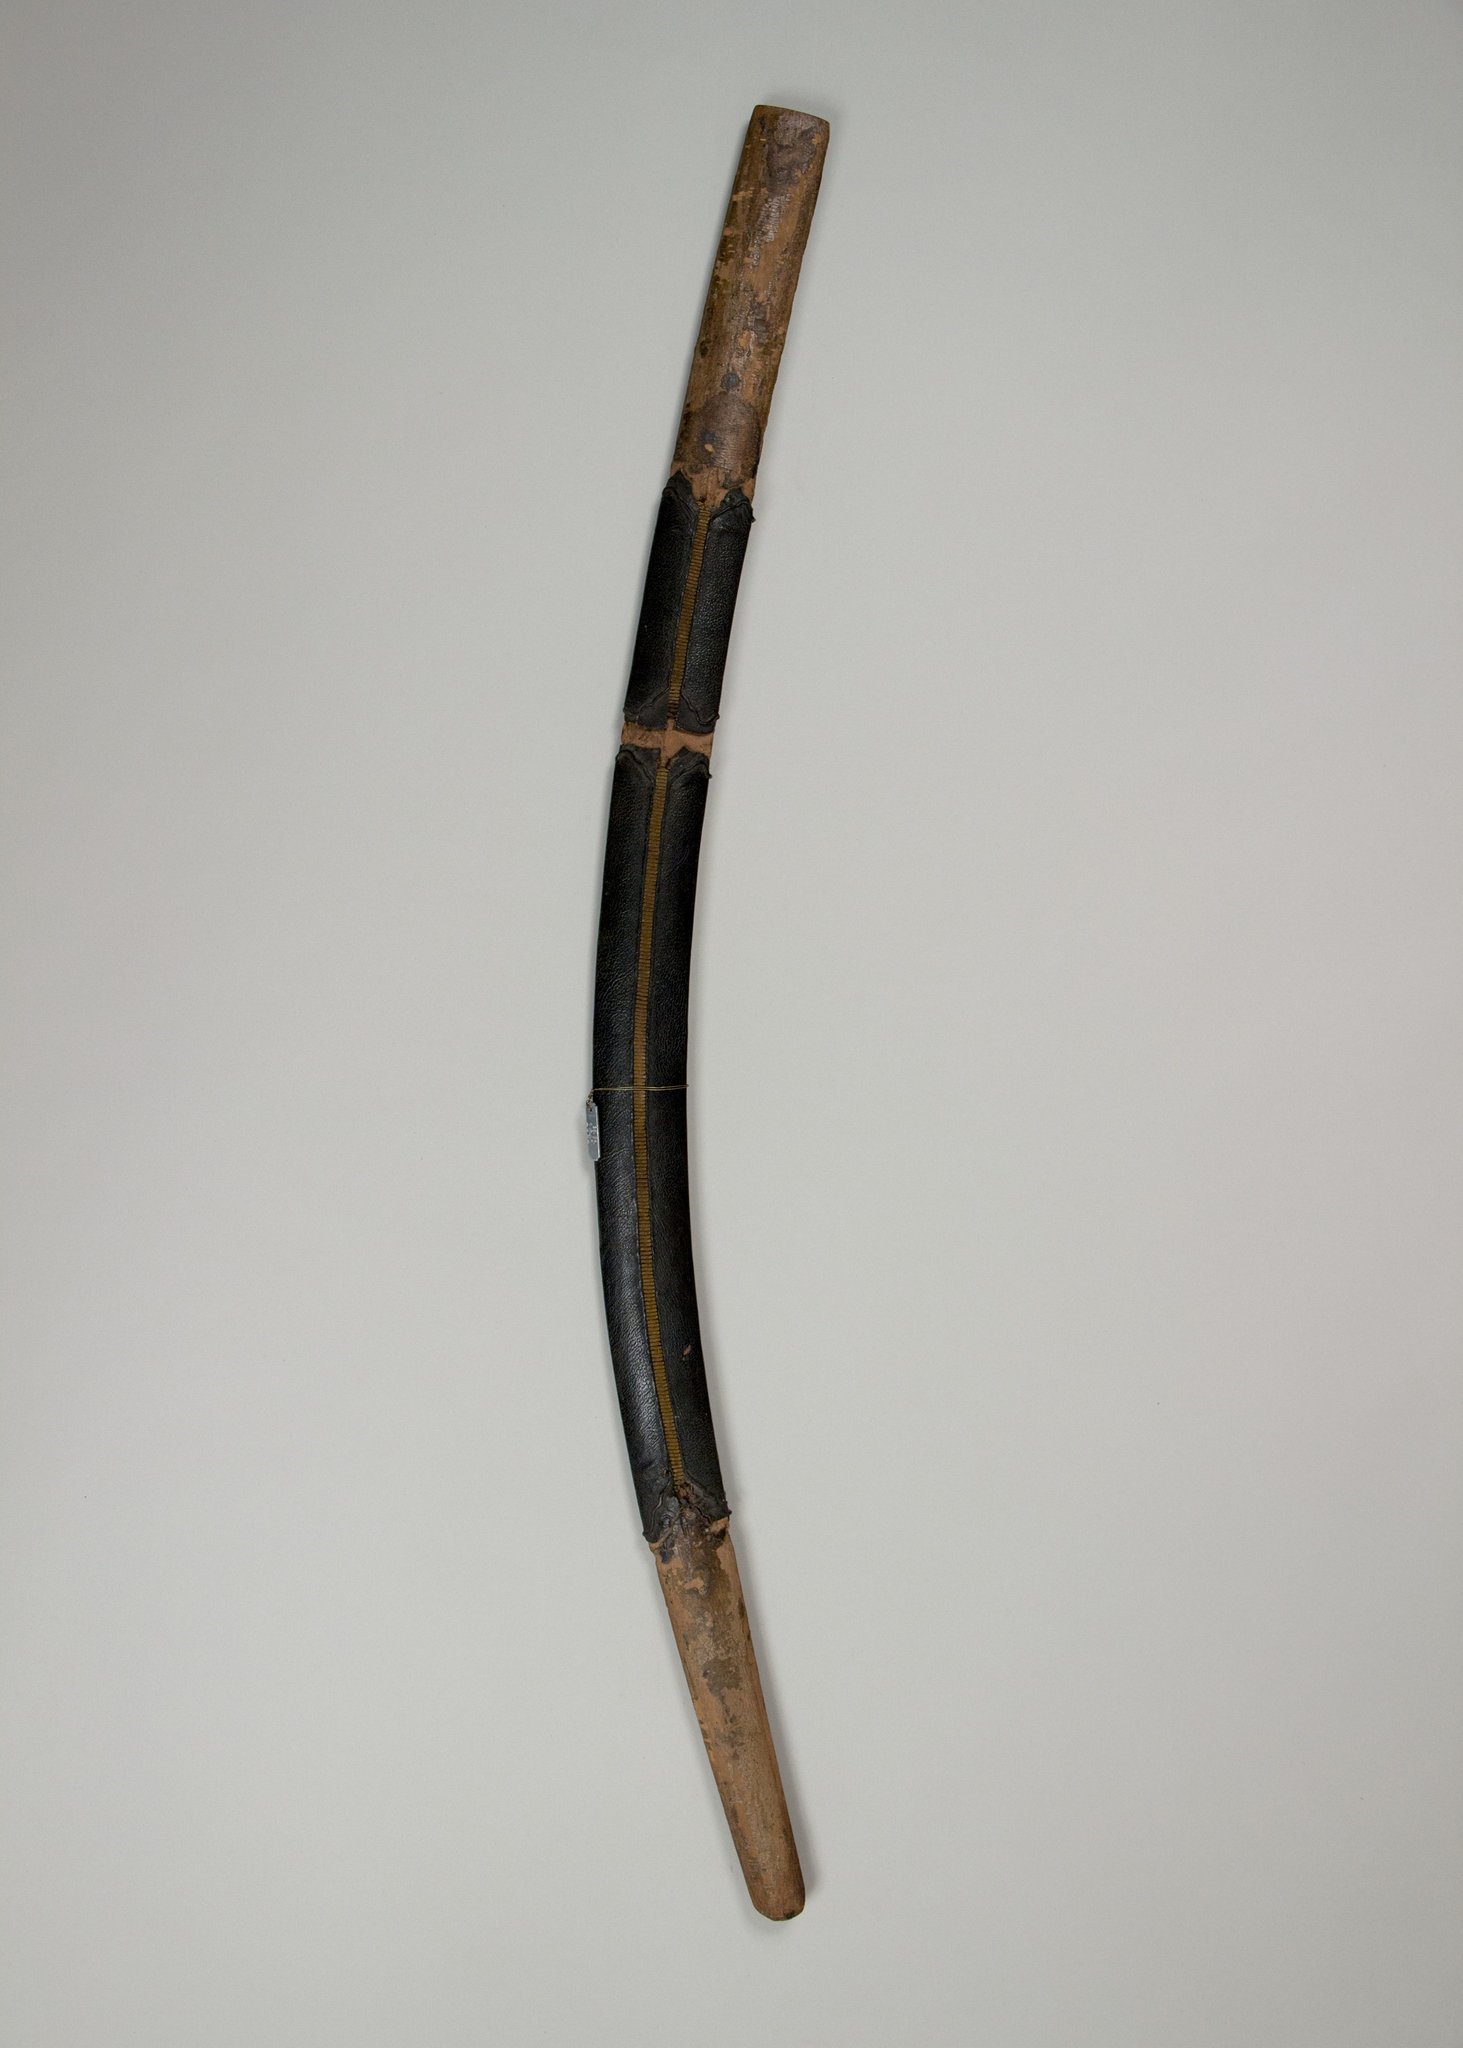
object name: sword with scabbard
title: Sword Scabbard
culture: persian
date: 1801-1900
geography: iran